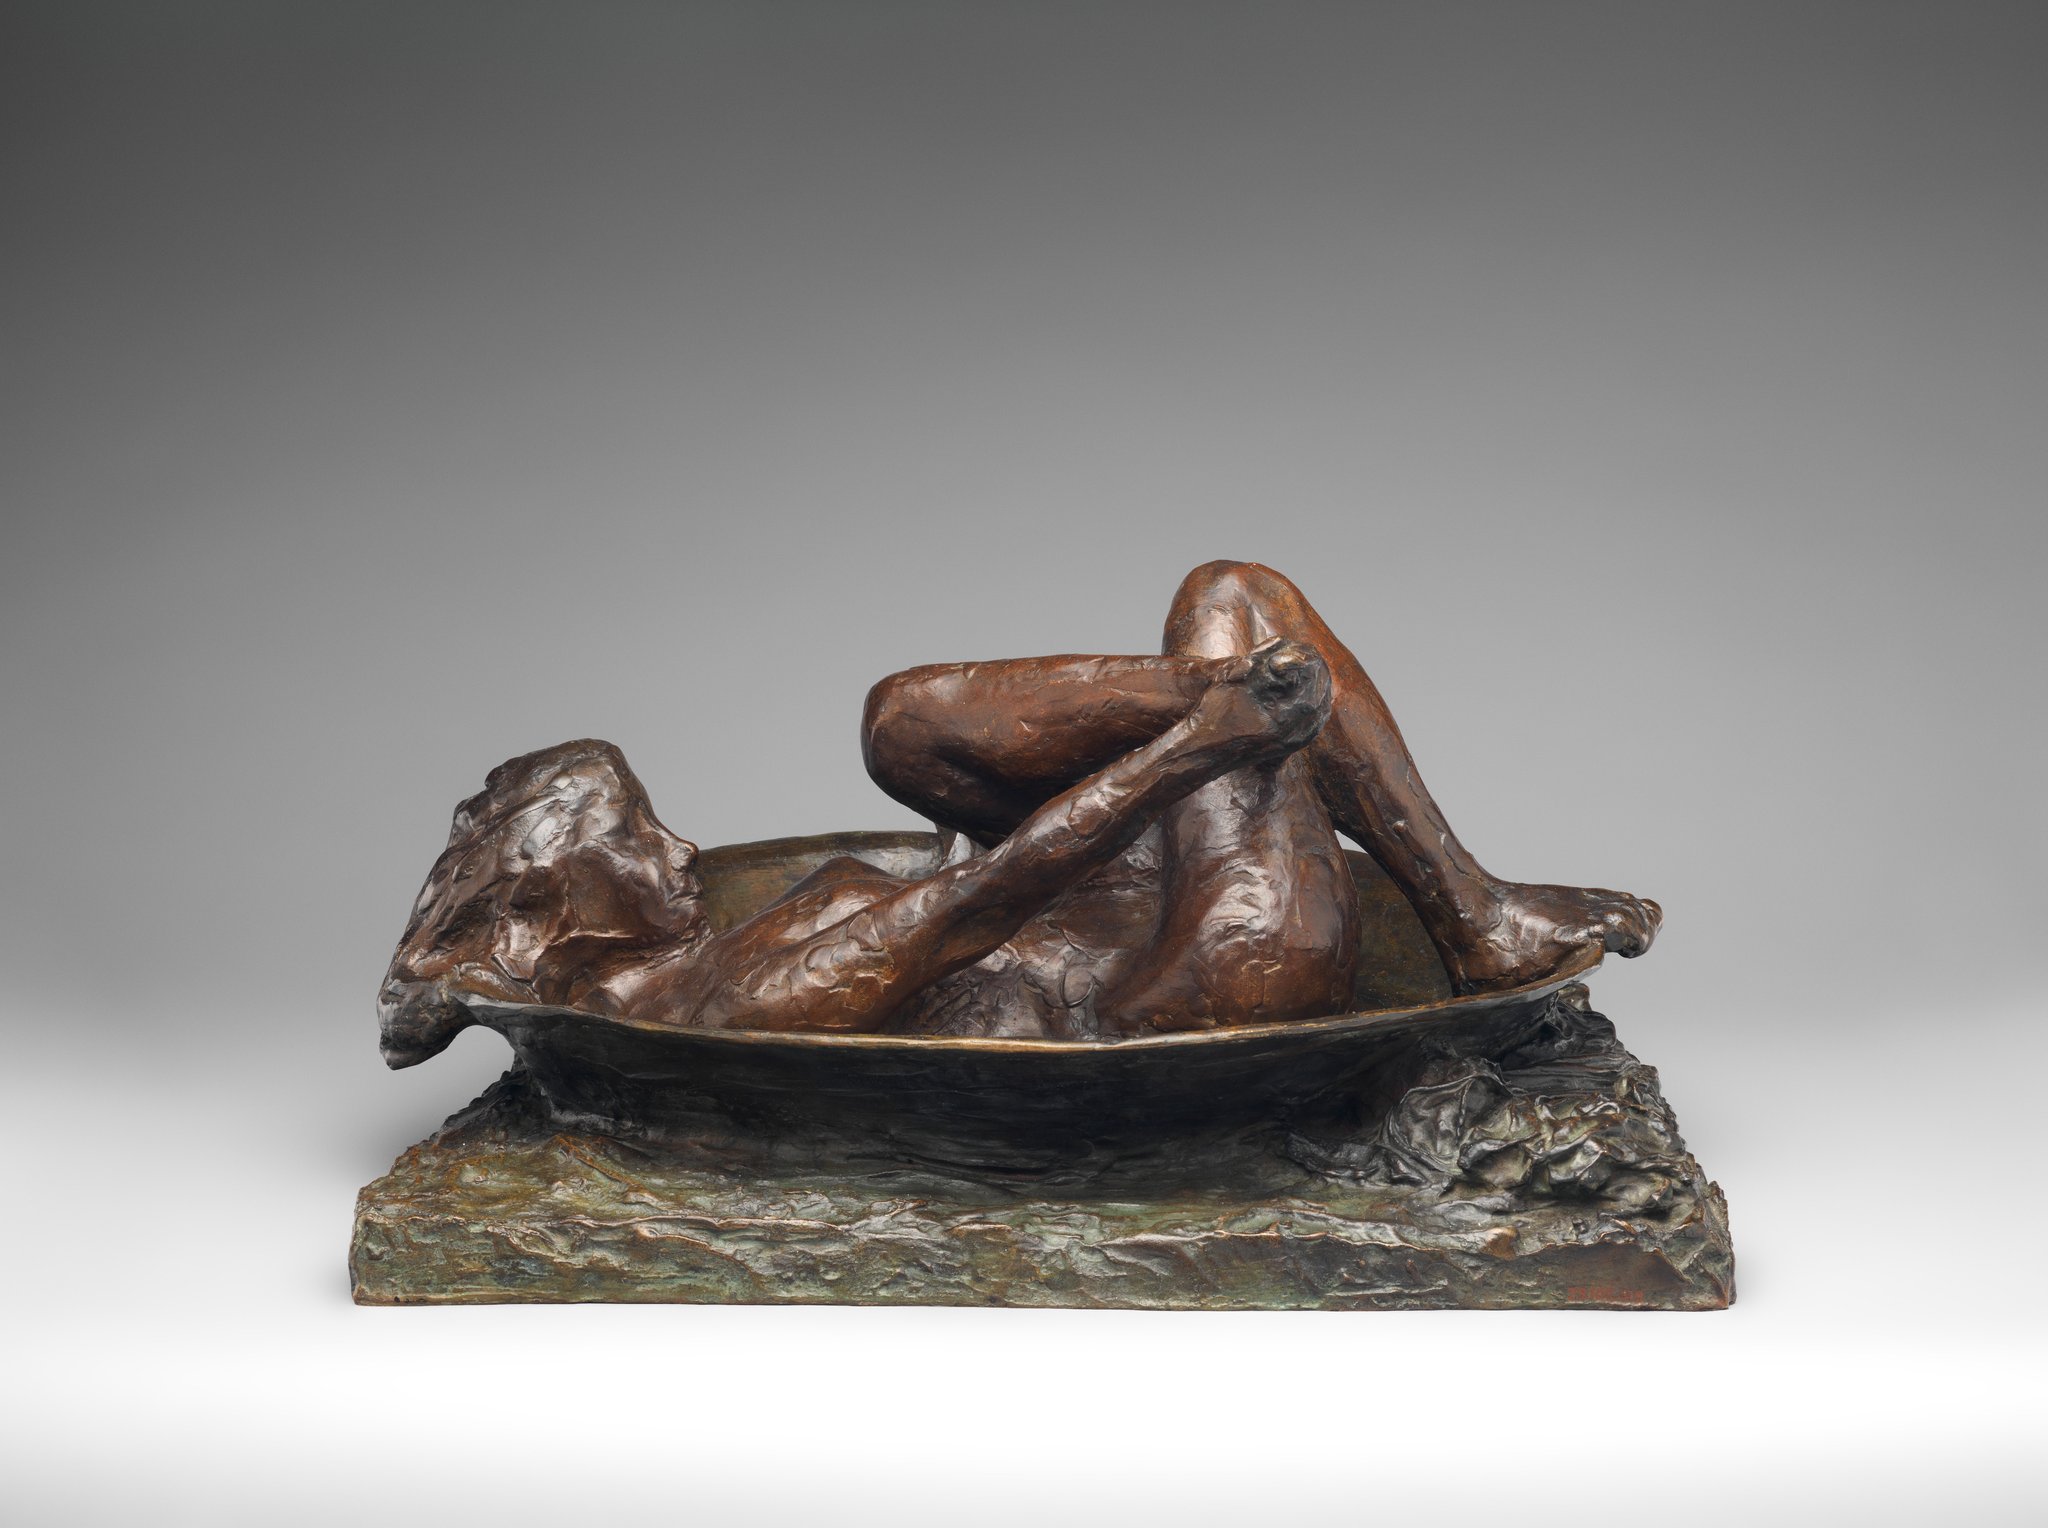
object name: sculpture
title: The Tub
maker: edgar degas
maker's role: artist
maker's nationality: french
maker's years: 1834-1917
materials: bronze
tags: female nudes,bathing